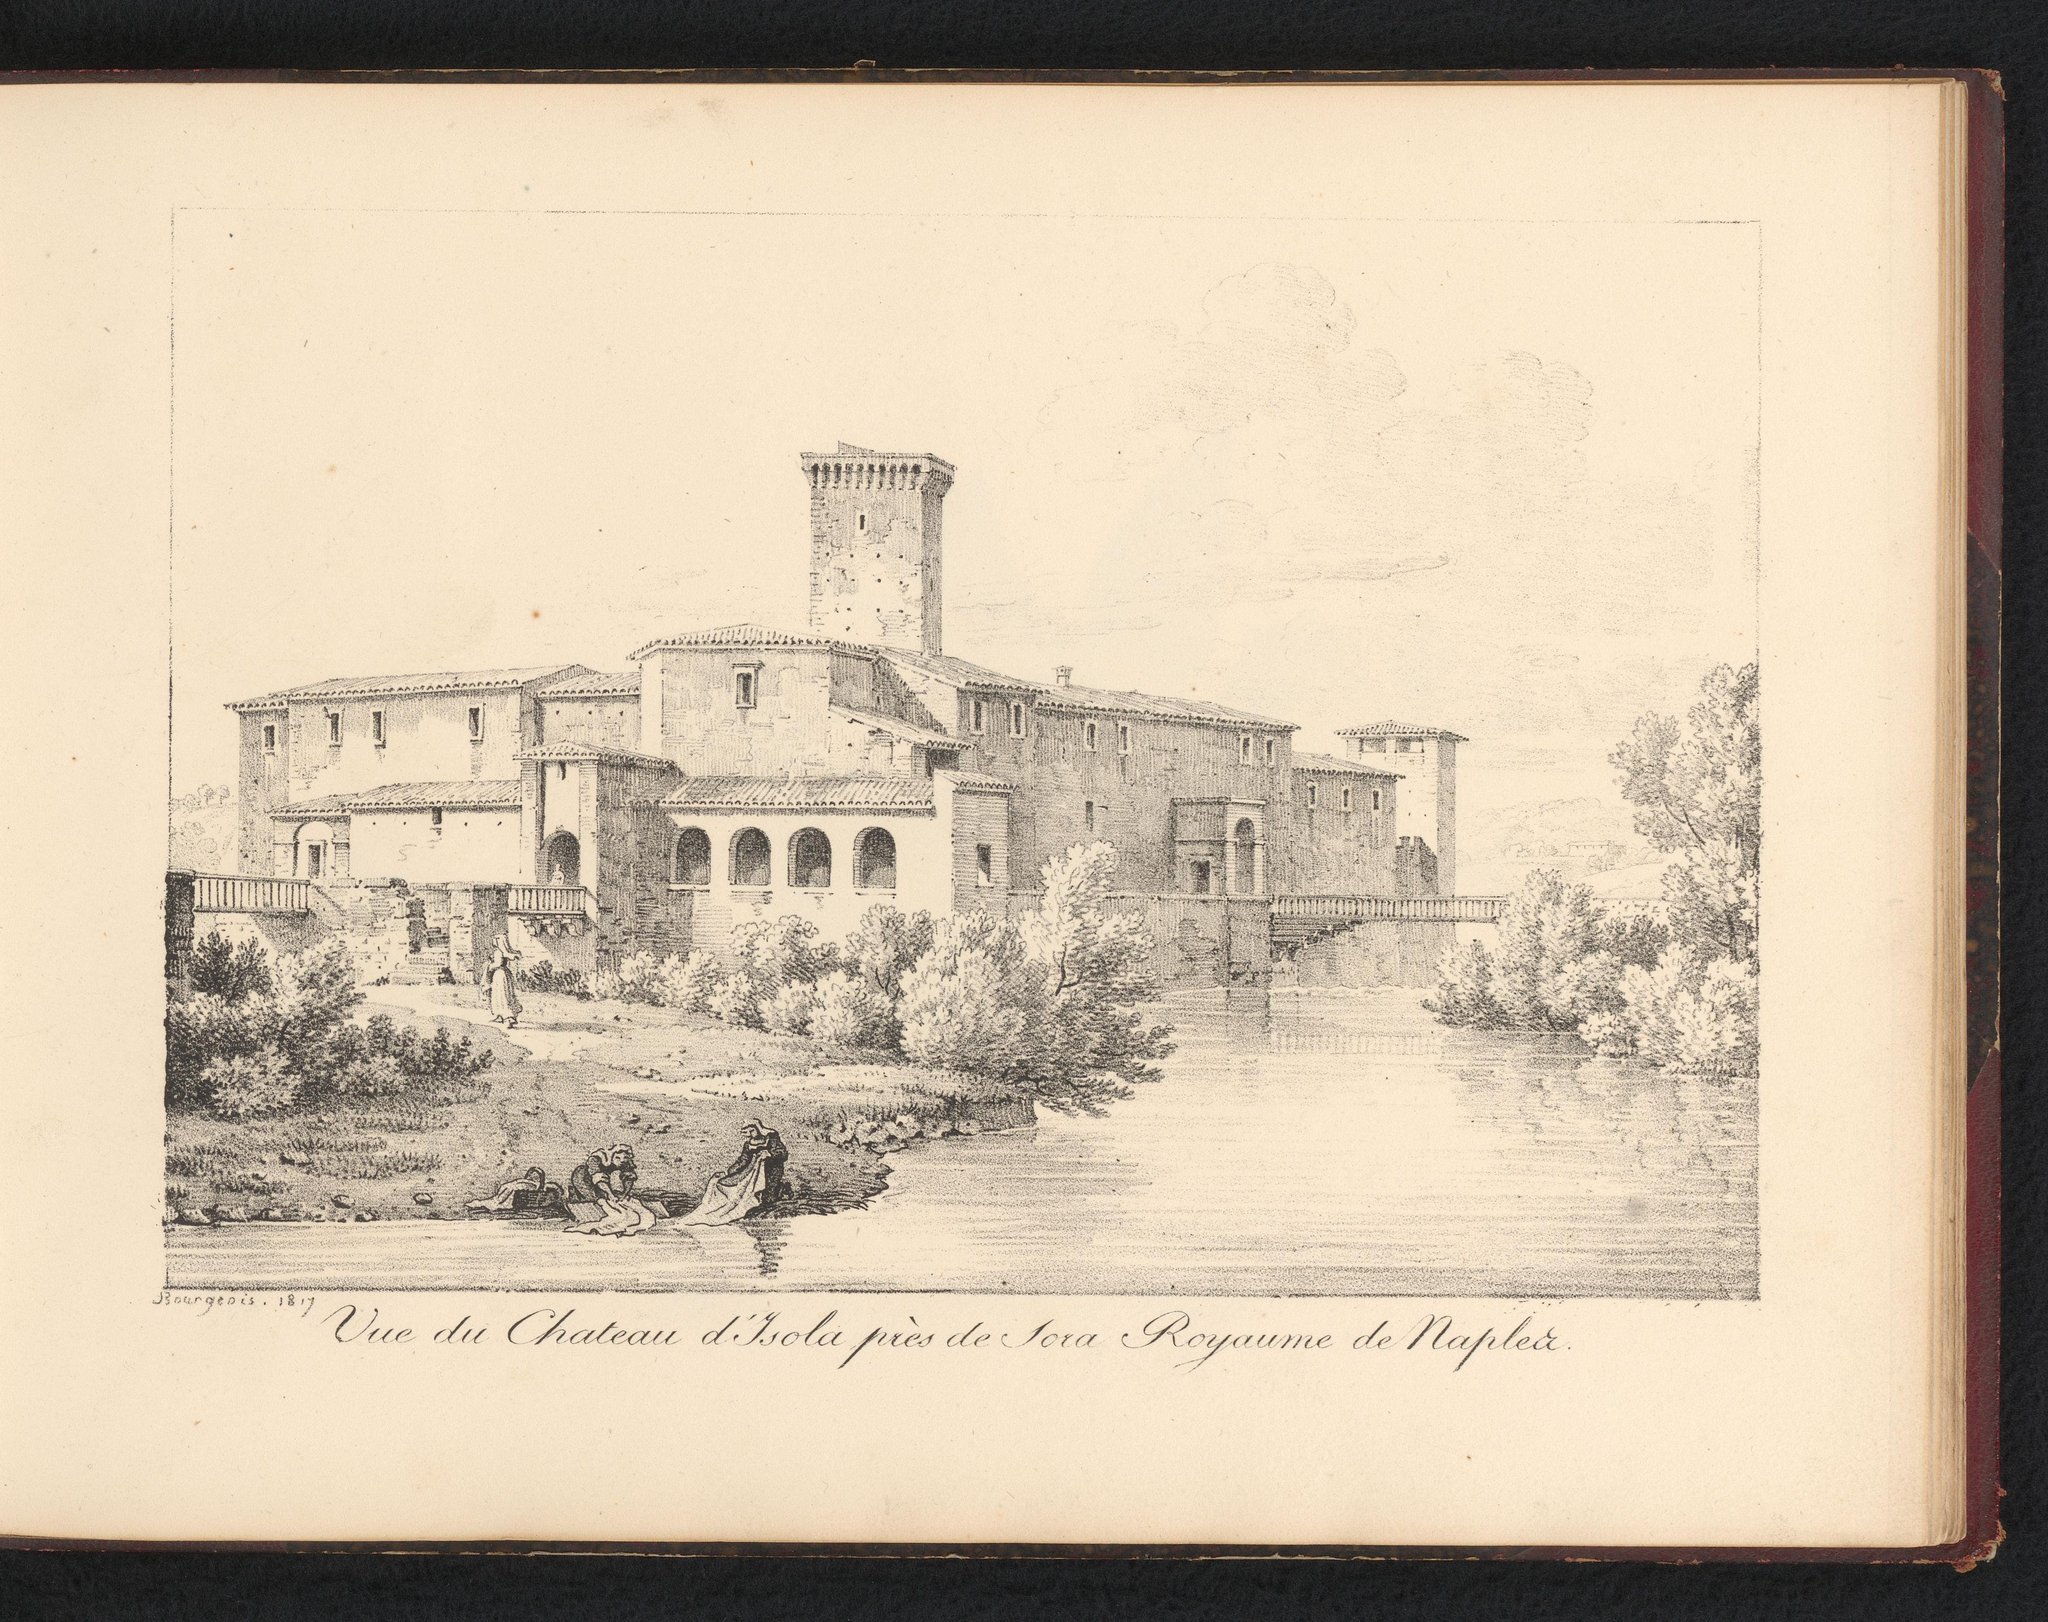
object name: print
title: Gezicht op een kasteel bij Napels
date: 1817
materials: paper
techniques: lithograph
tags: landscape with tower or castle, naples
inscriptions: collector's mark: Lugt 2228, collector's mark: Lugt 2760